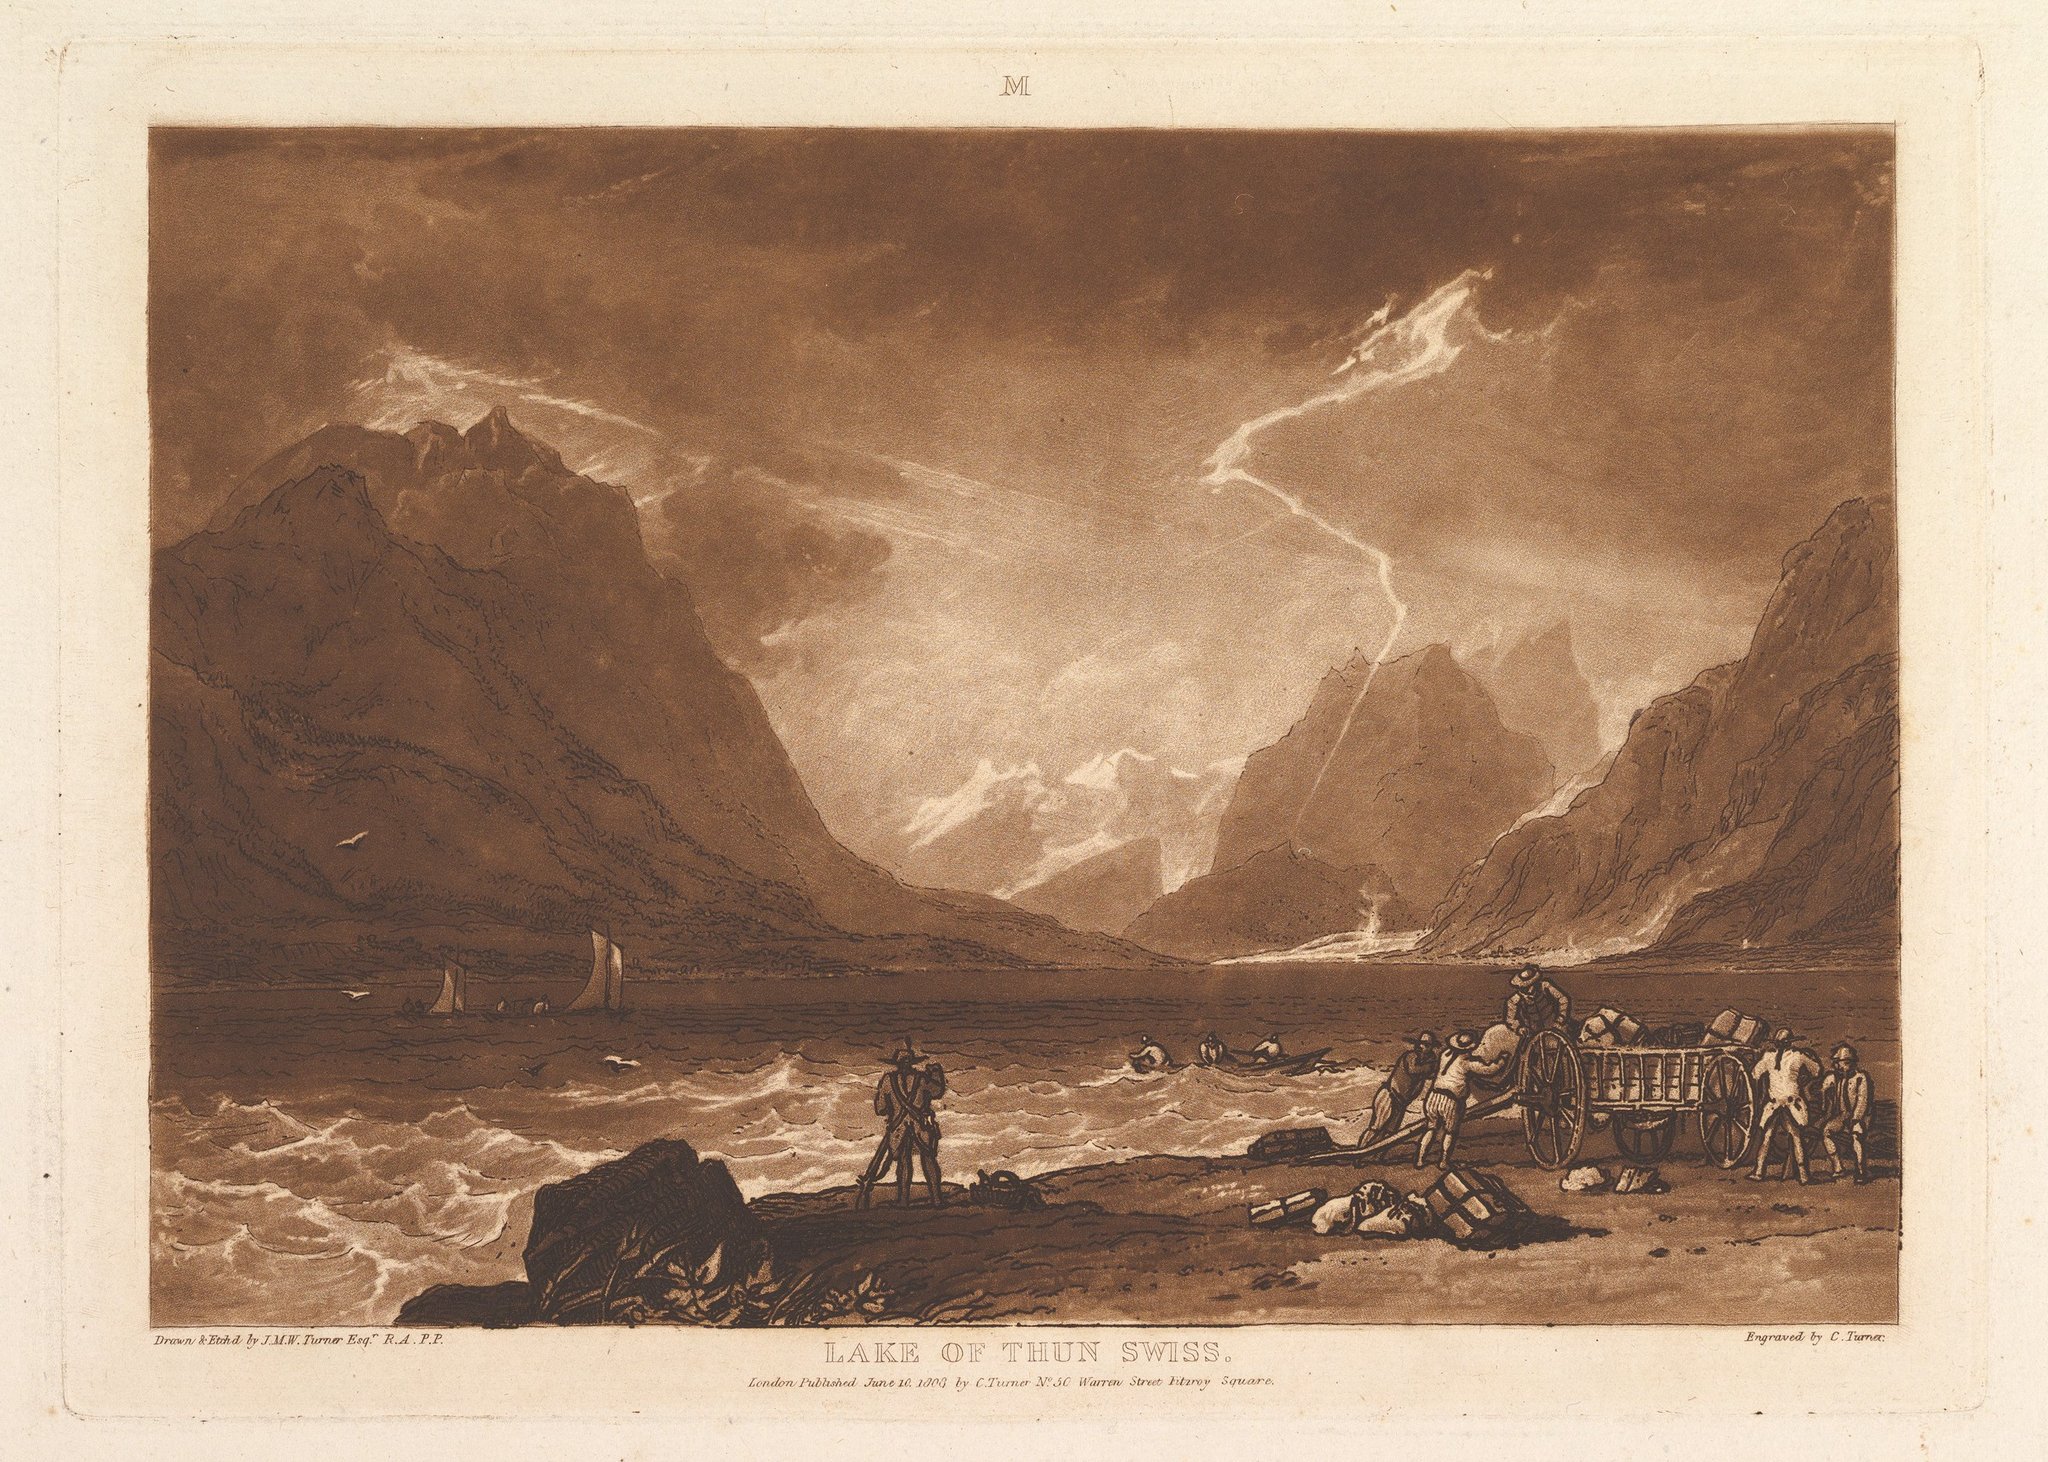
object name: print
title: Lake of Thun, Swiss (Liber Studiorum, part III, plate 15)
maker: joseph mallord william turner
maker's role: artist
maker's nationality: british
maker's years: 1775-1851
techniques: drypoint, etching, mezzotint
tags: lakes,landscapes,boats